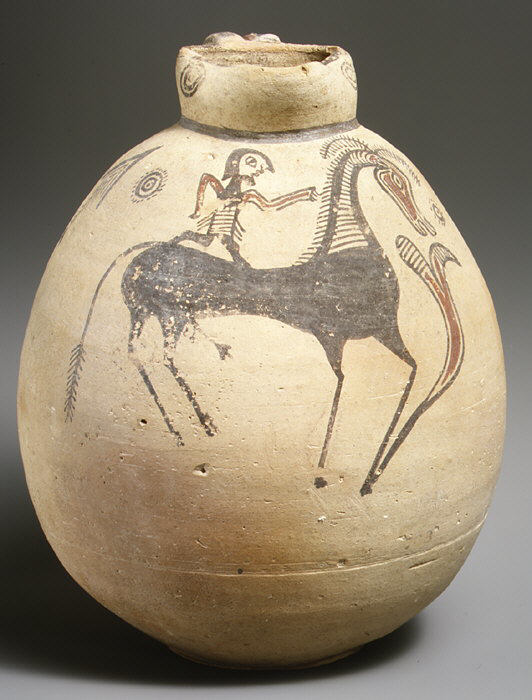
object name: jug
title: Terracotta jug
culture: cypriot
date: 750-600 BCE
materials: terracotta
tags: horses